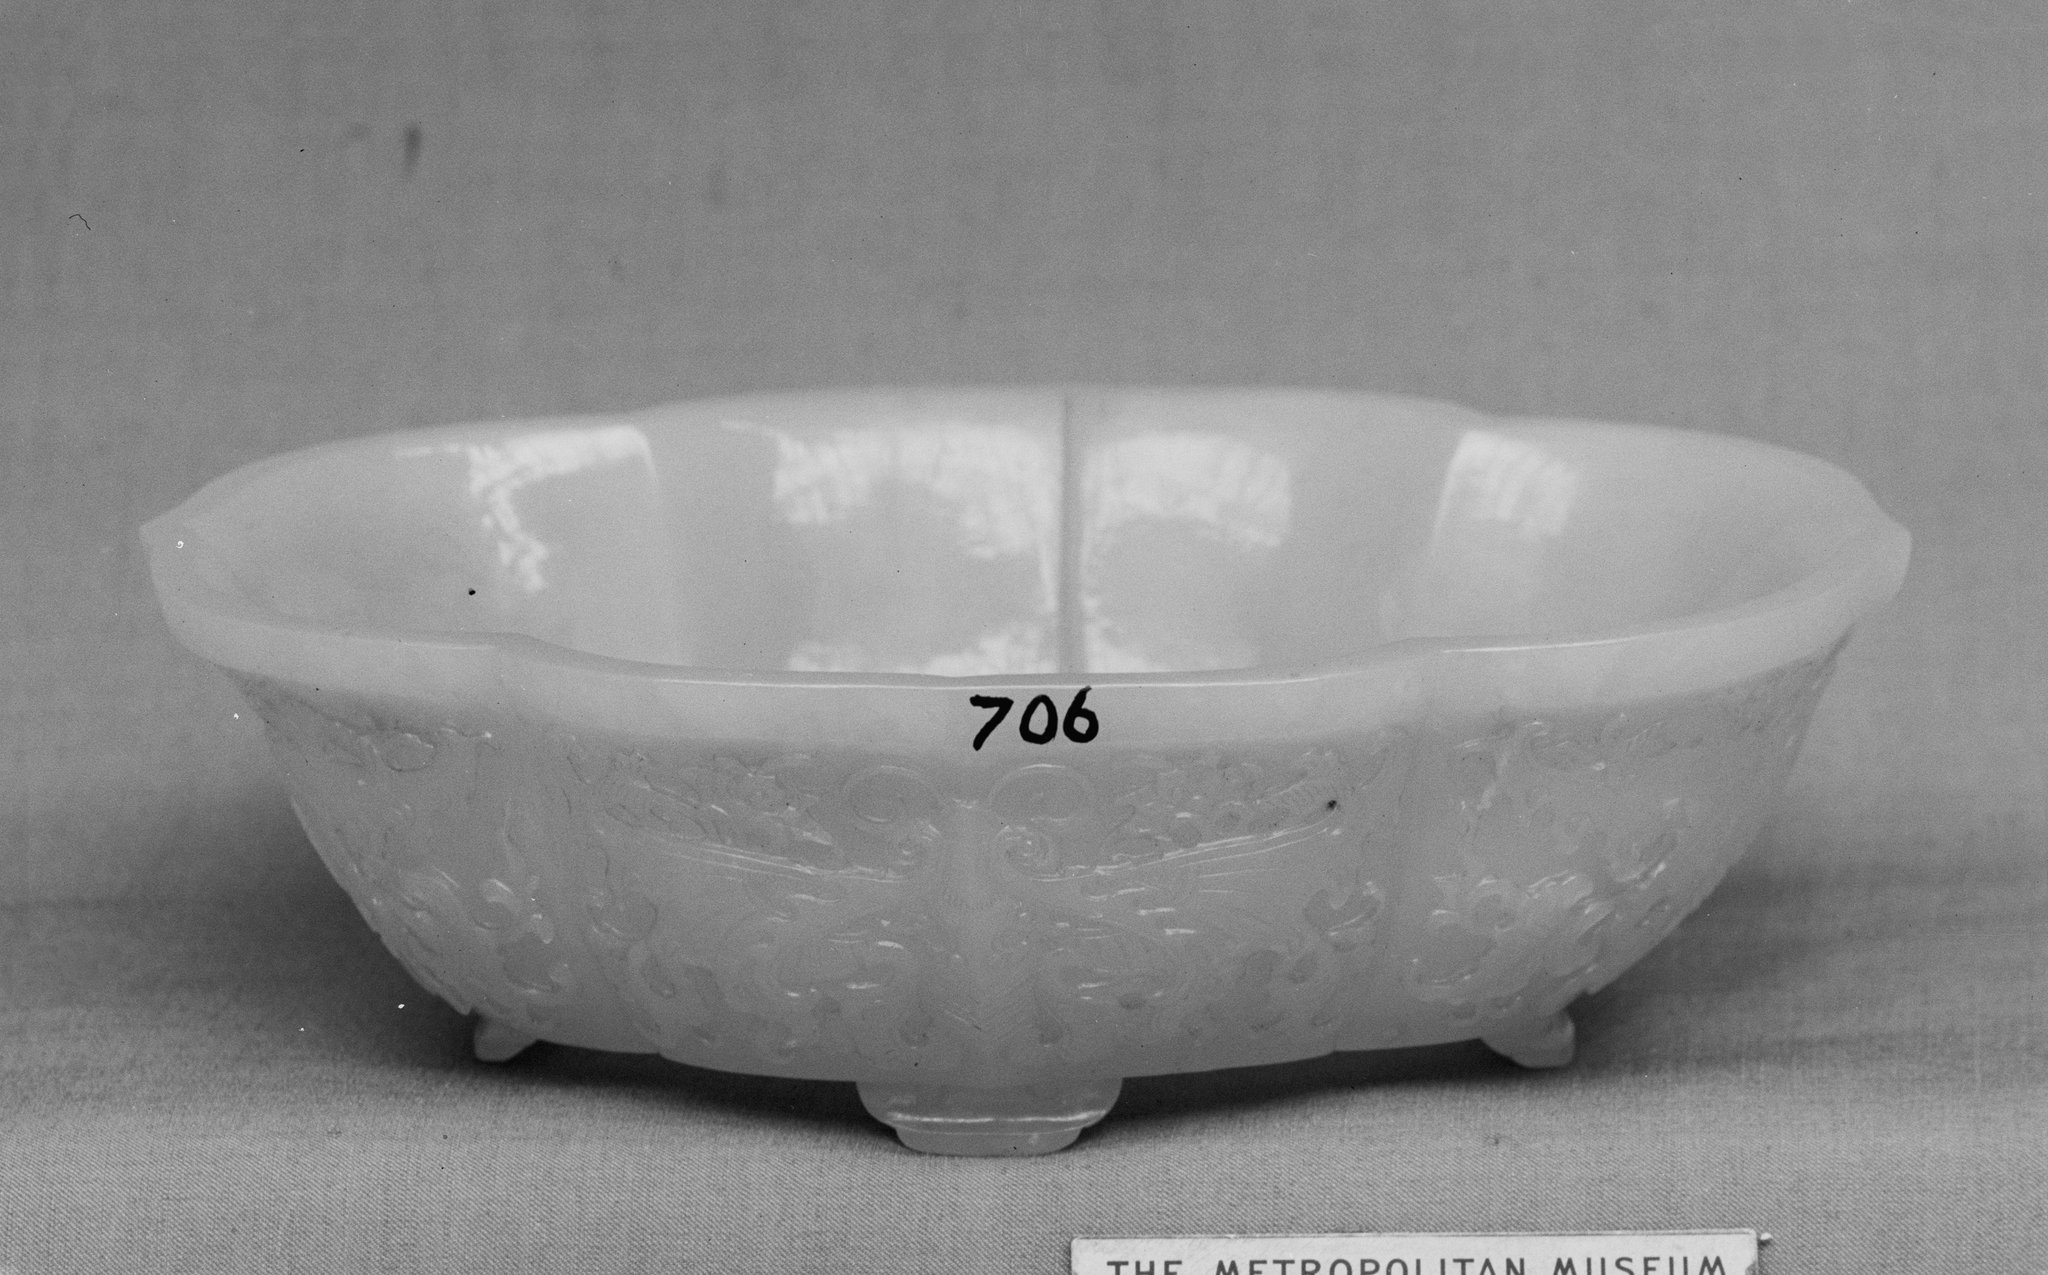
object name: brush washer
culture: chinese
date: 1701-1800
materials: jade